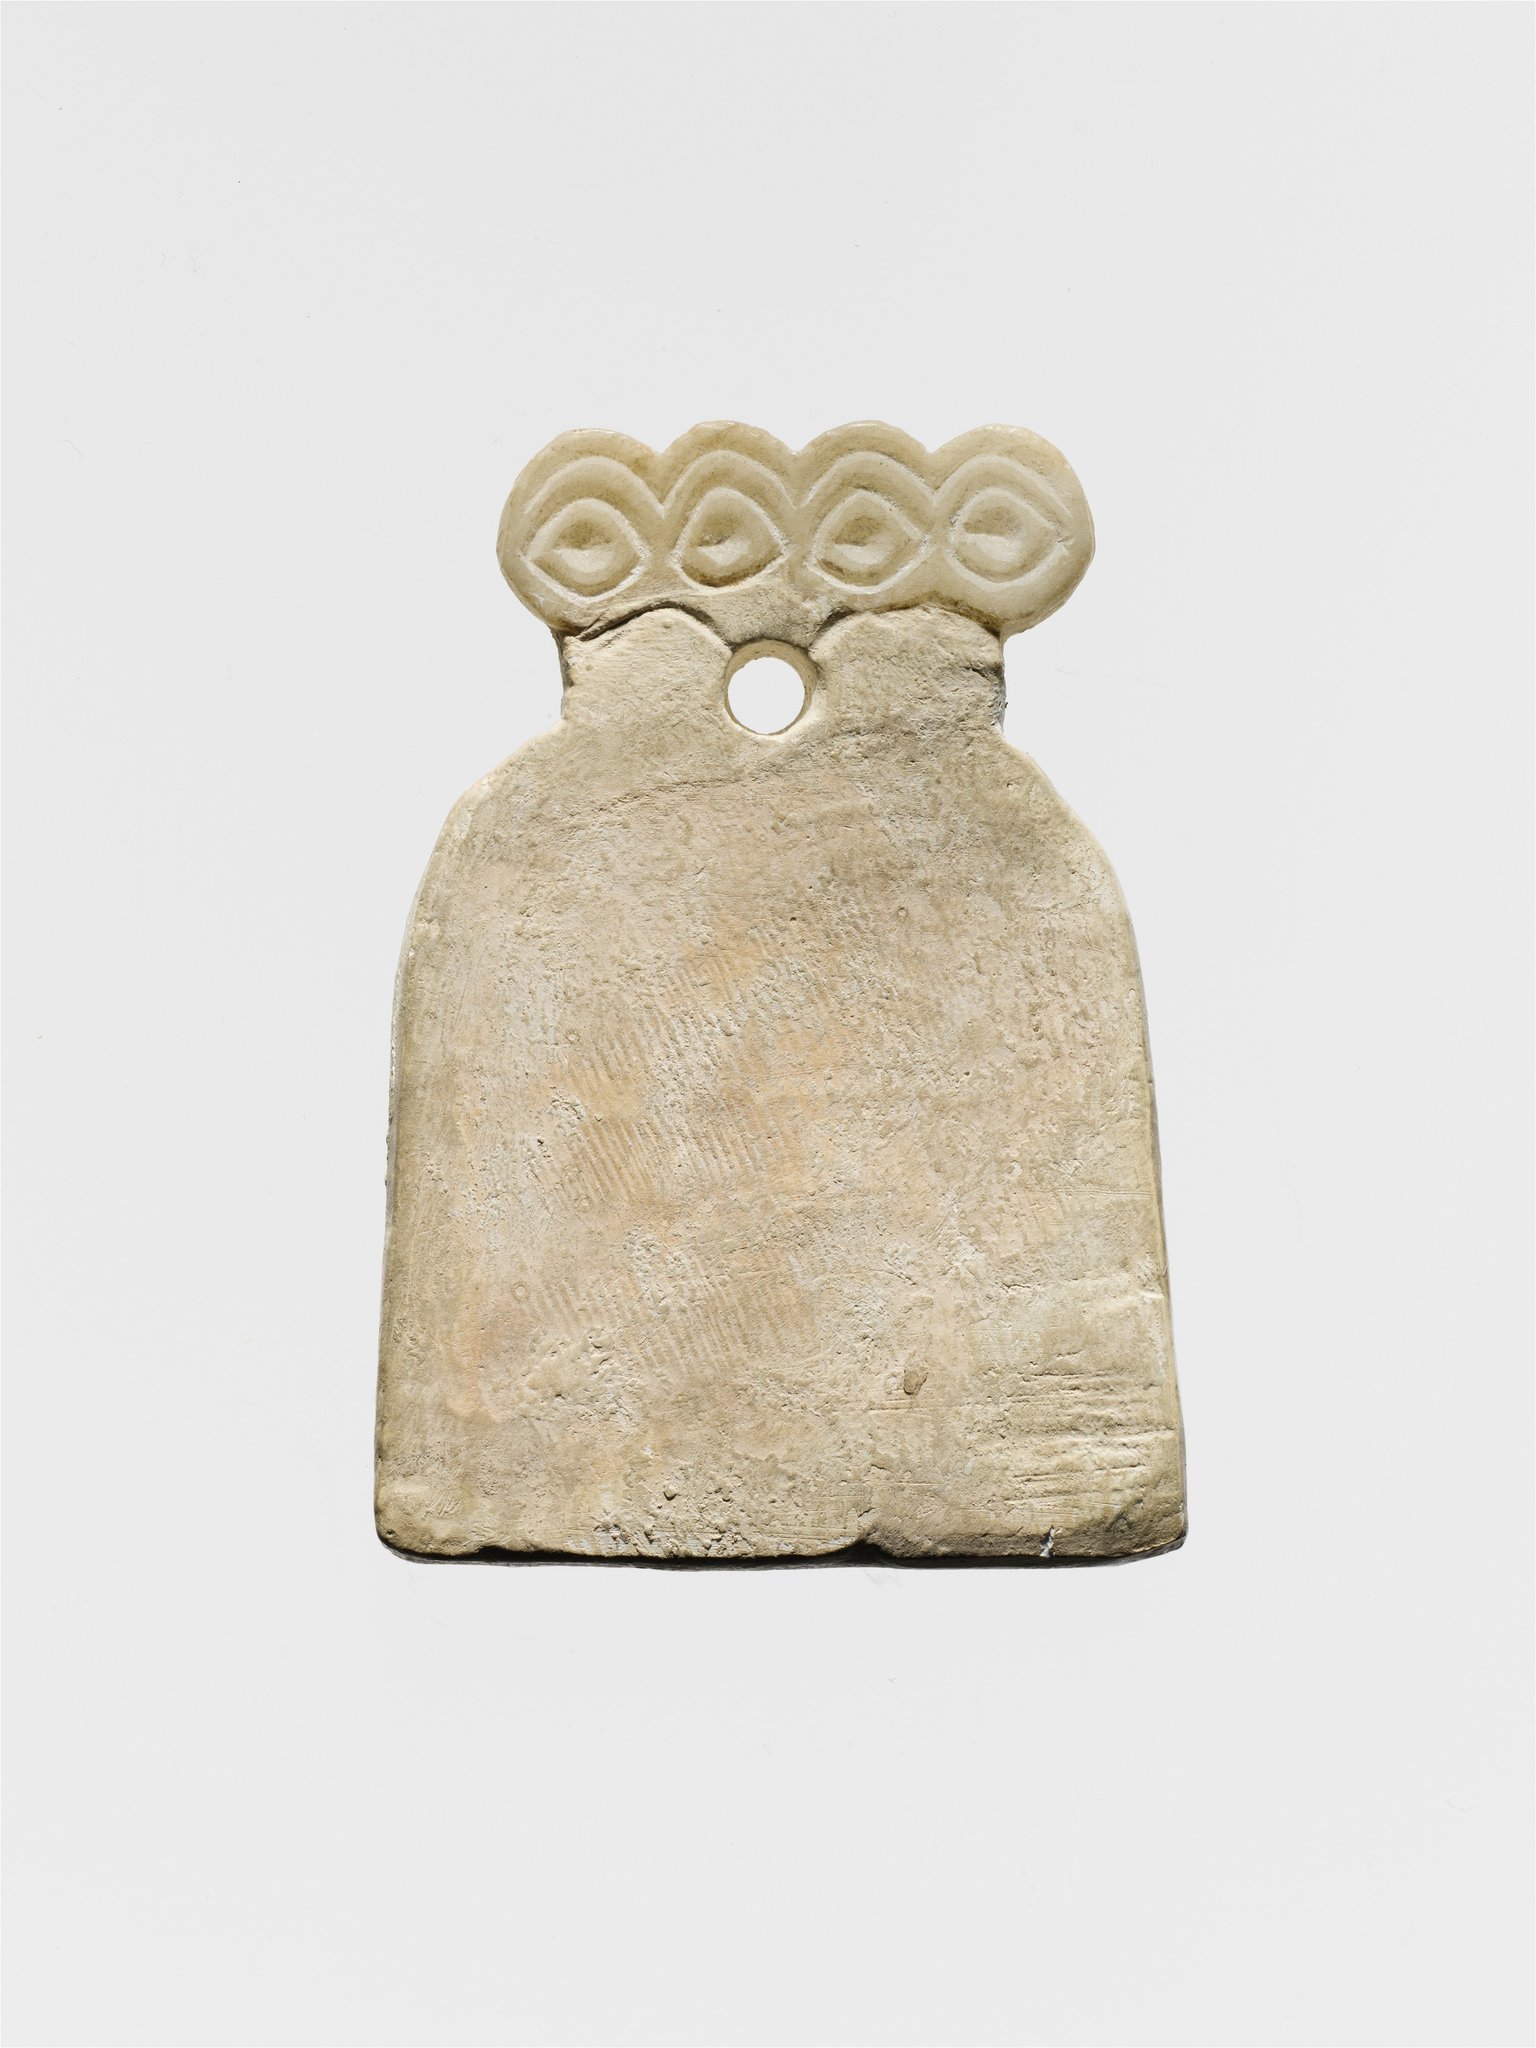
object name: sculpture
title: Eye idol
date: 3700-3500 BCE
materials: alabaster, gypsum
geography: syria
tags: eyes